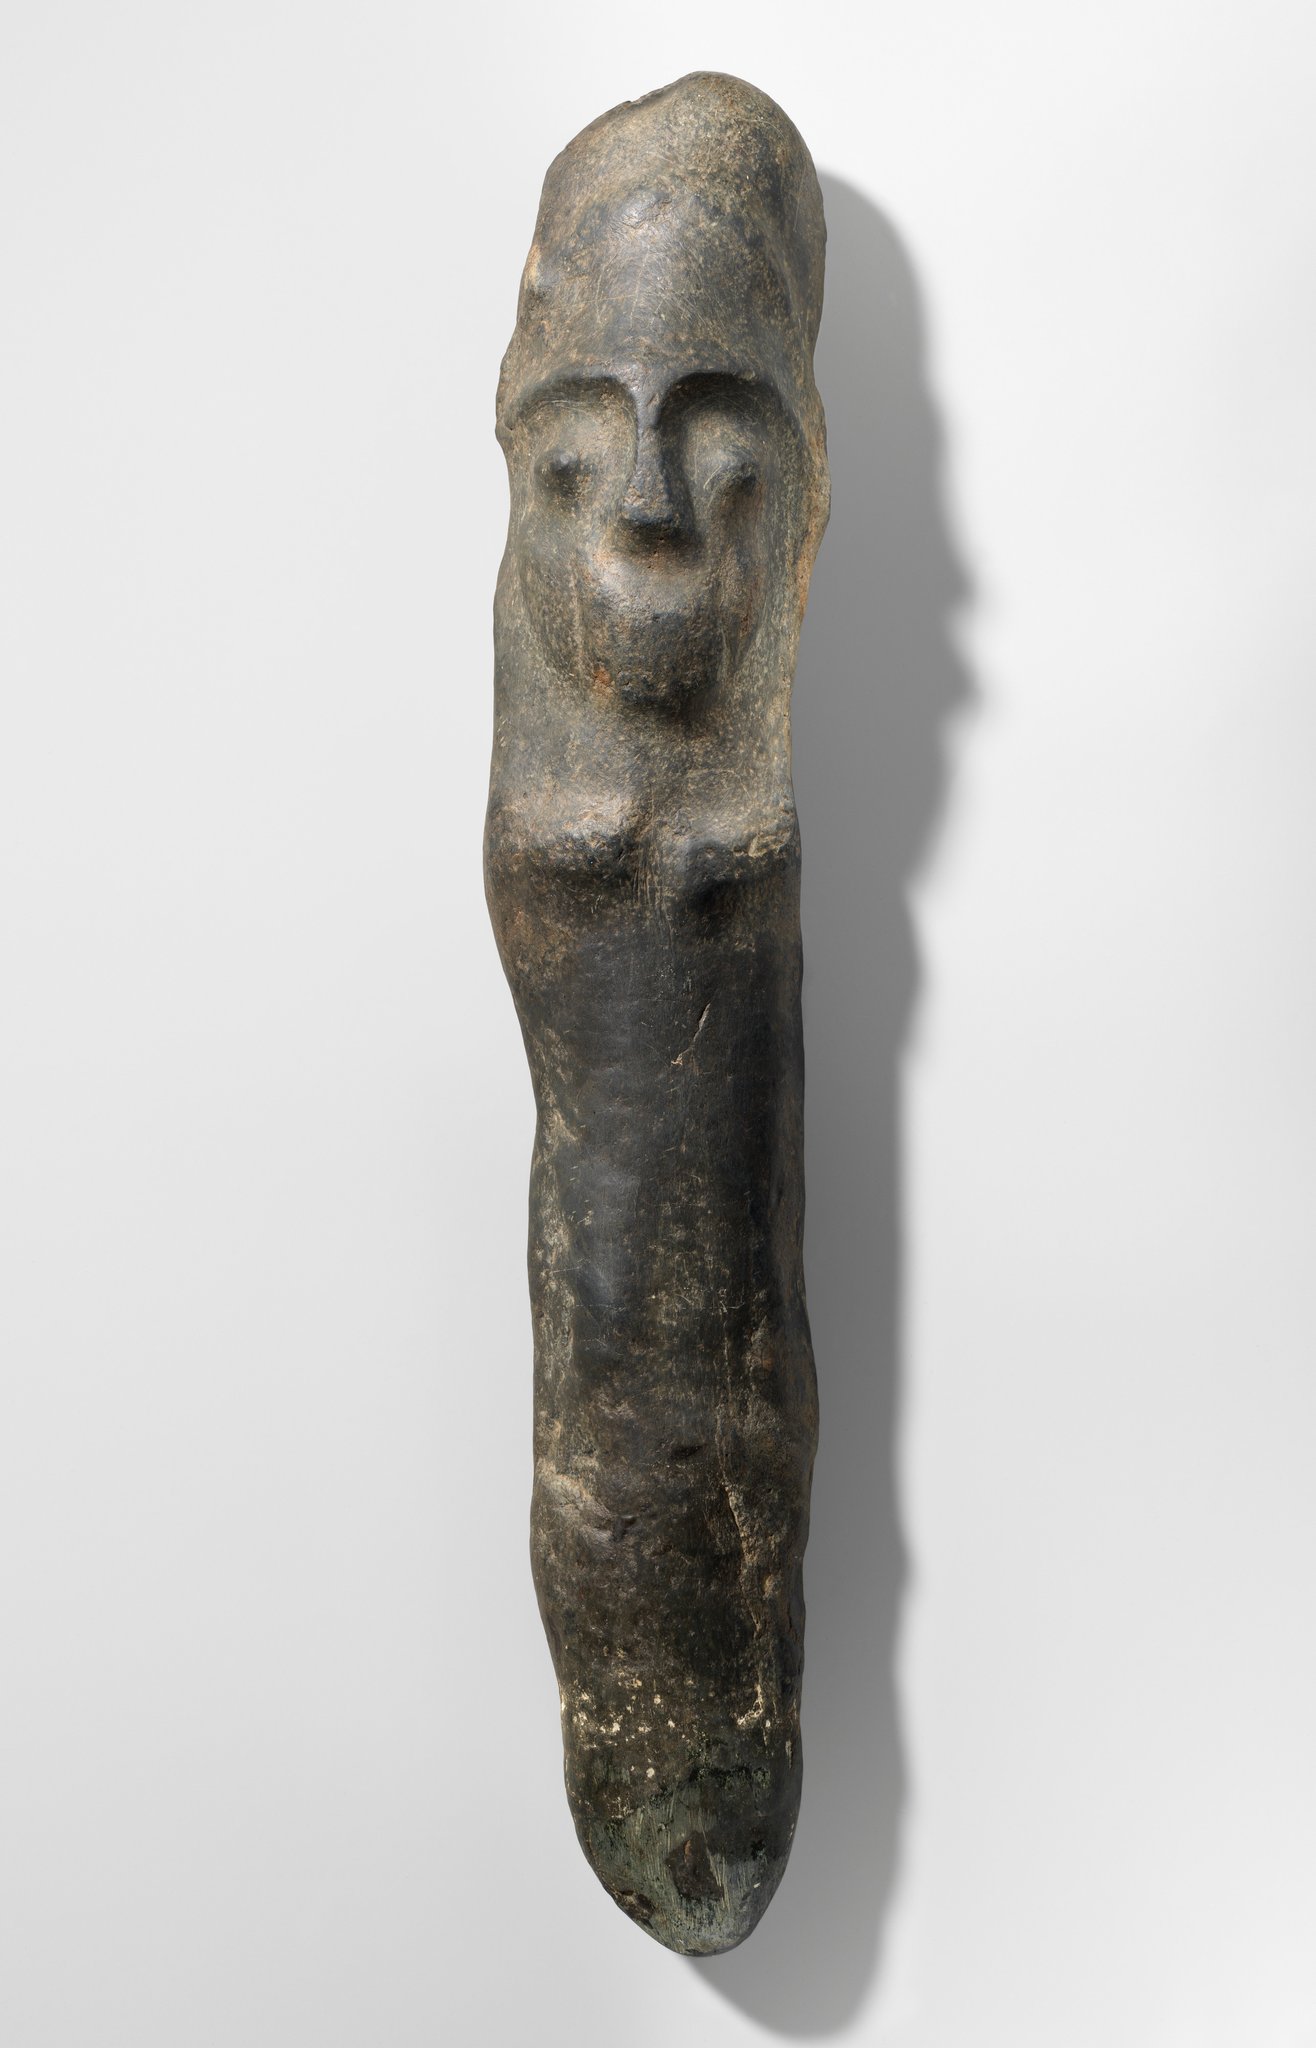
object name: axe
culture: taíno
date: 901-1500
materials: stone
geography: dominican republic